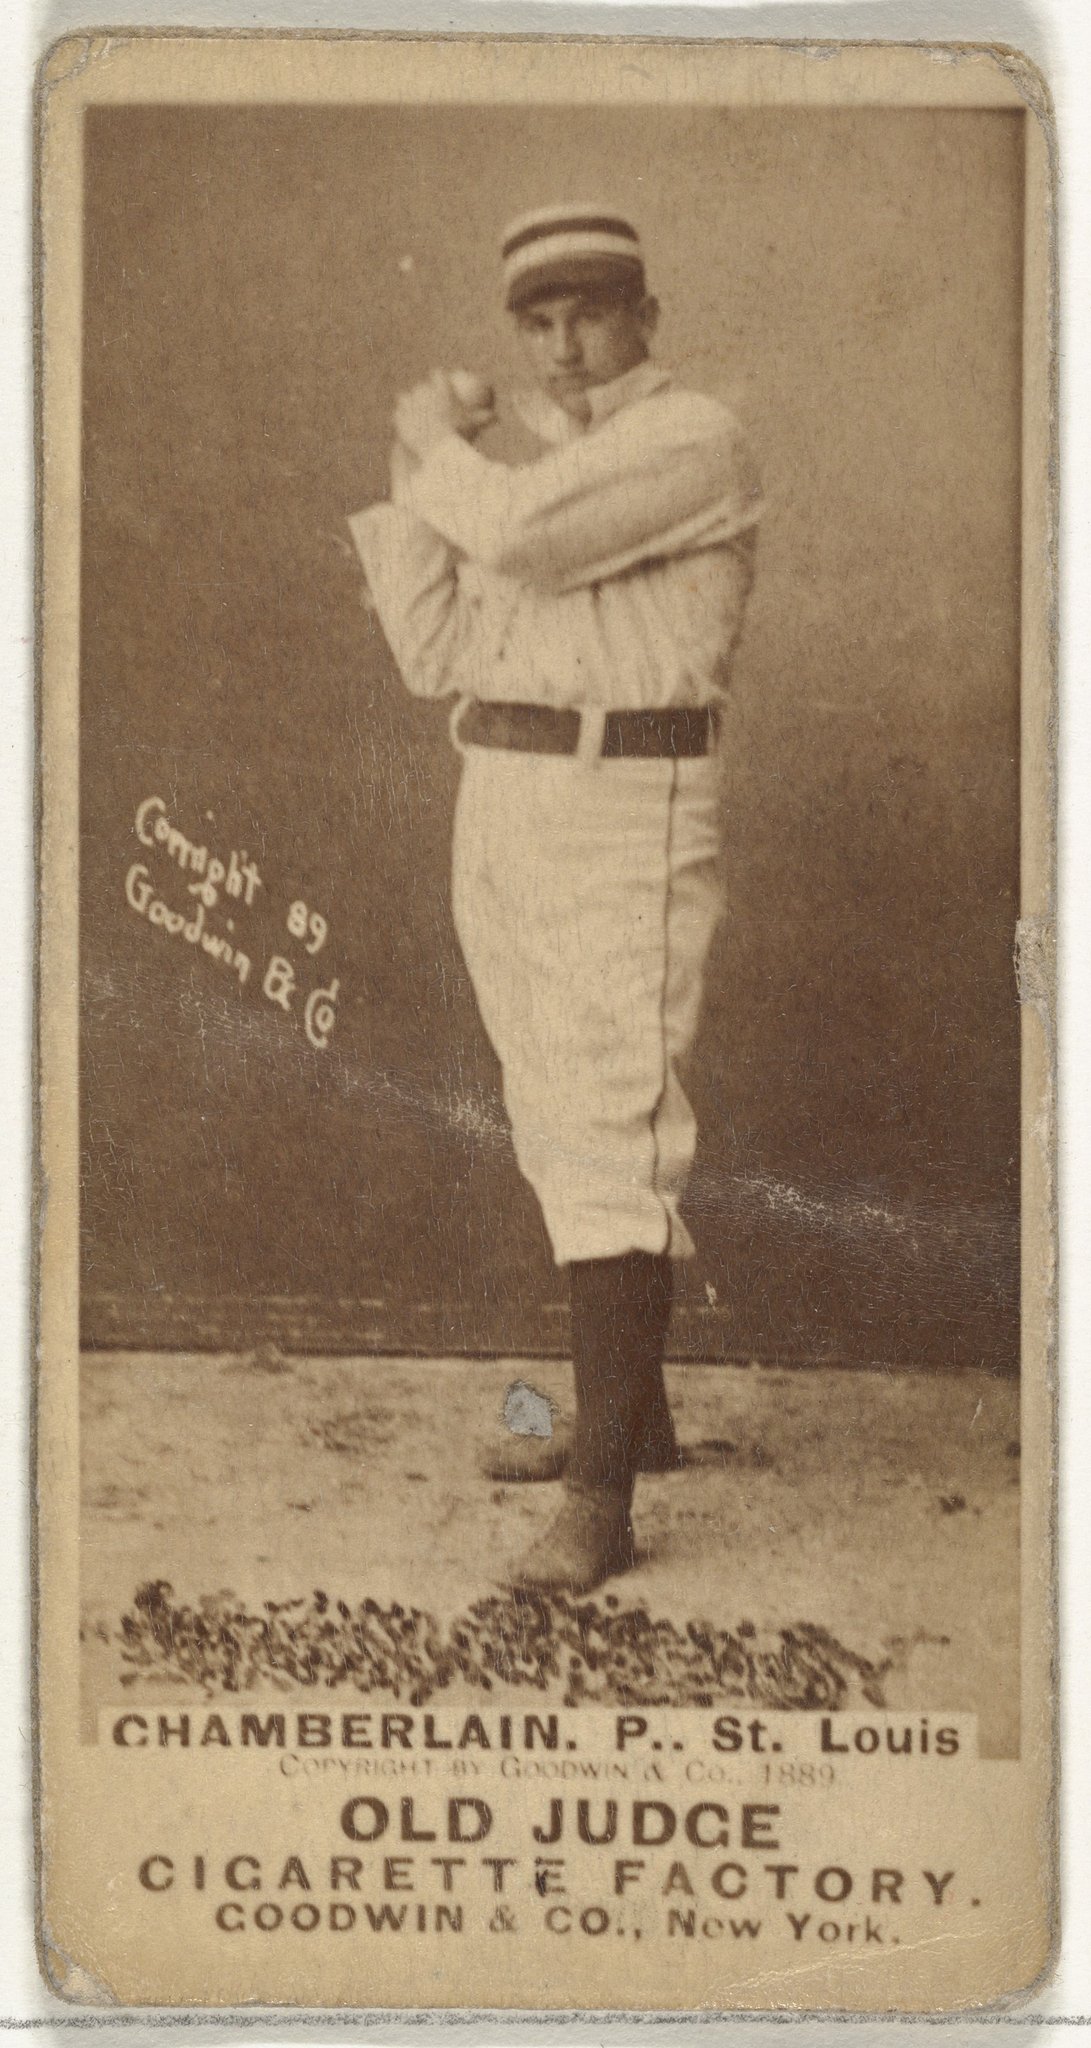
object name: baseball card, photograph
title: Elton P. "Ice Box" Chamberlain, Pitcher, St. Louis Browns, from the Old Judge series (N172) for Old Judge Cigarettes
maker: goodwin & company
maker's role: publisher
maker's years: 1850-1950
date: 1889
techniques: albumen silver print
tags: men,portraits,baseball,athletes